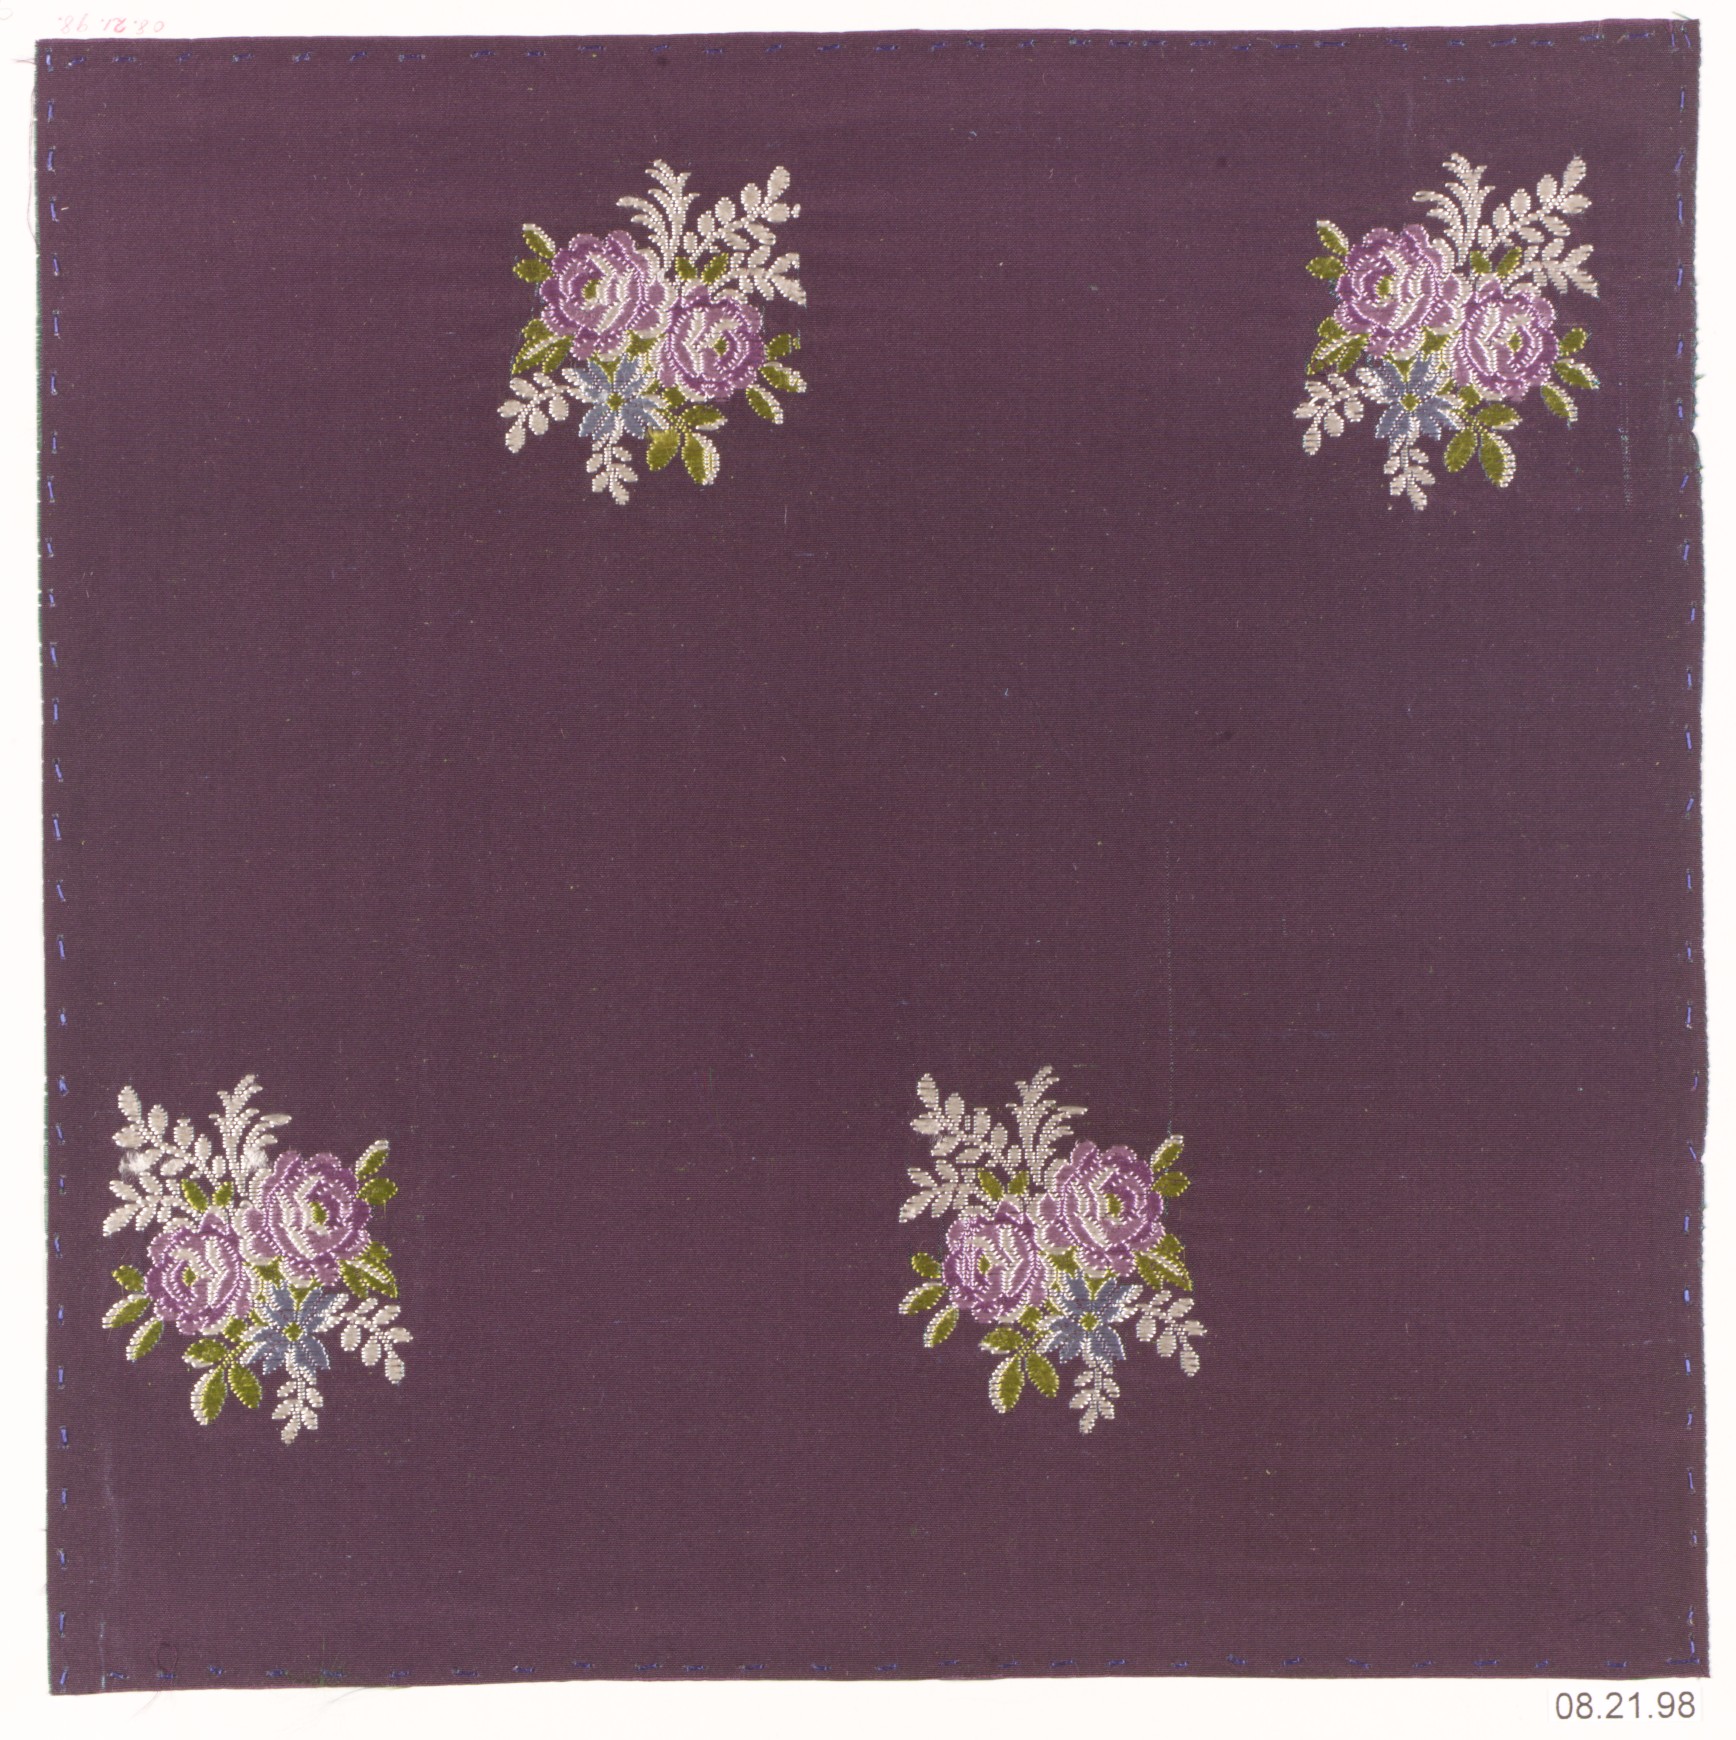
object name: textile sample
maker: Anonymous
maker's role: designer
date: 1900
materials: silk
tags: flowers